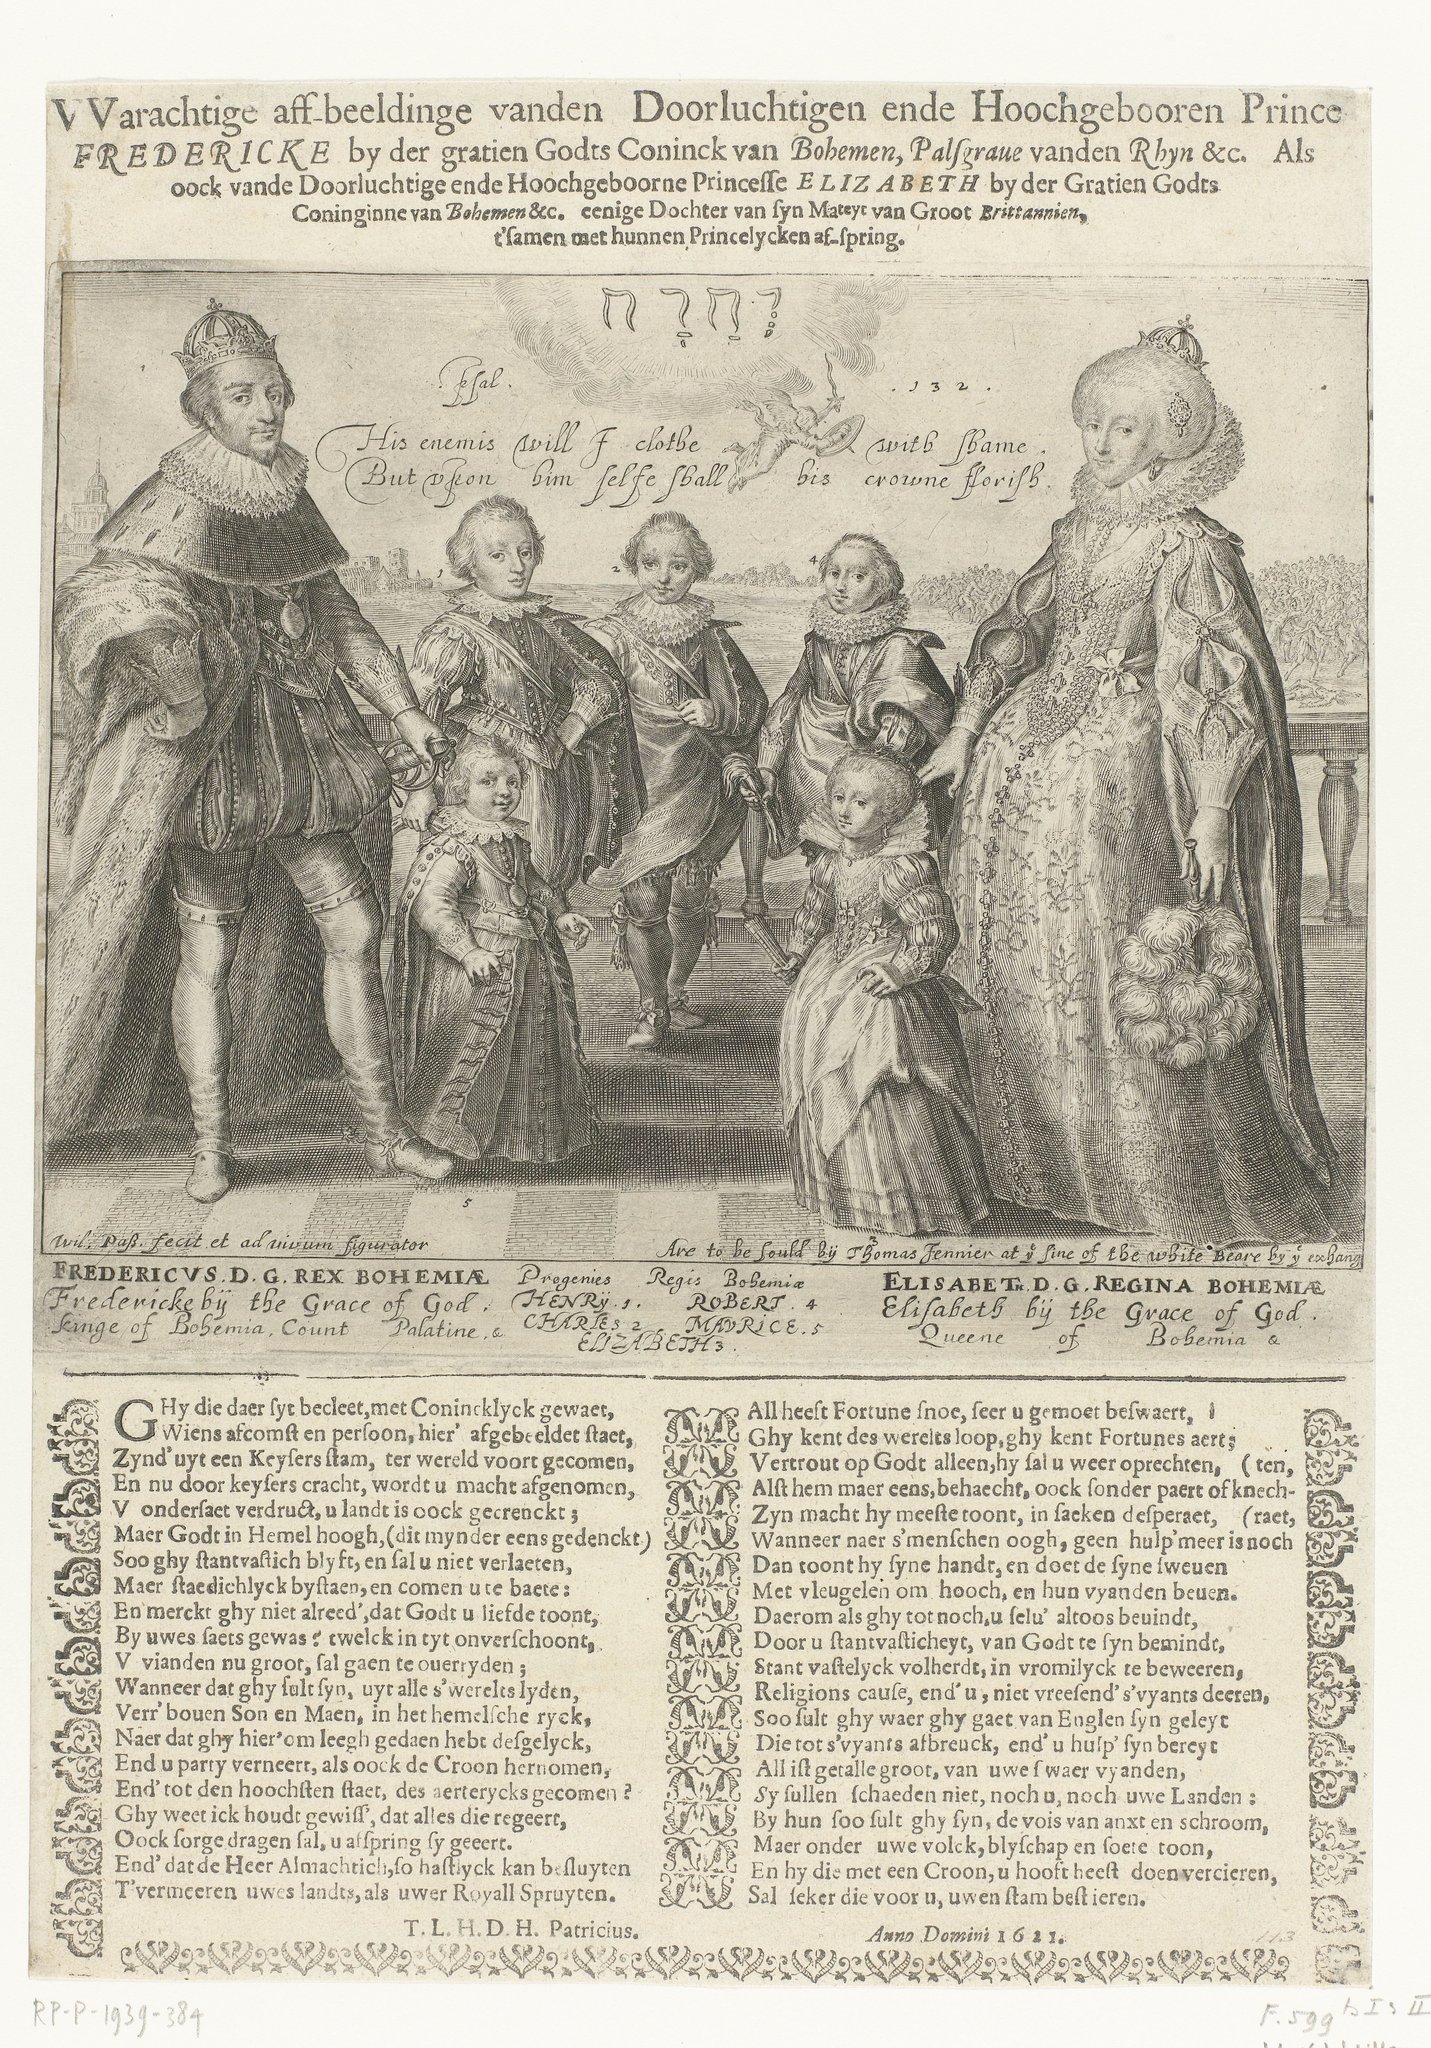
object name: print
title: Portret van Frederik V van Bohemen, zijn echtgenote Elisabeth Stuart en hun vijf kinderen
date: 1621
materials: paper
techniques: engraving, letterpress printing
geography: london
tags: prague, london, painter, draughtsman, prinz ruprecht, amberg, frederik v (keurvorst van de palts, koning van bohemen), tetragram (in hebrew script) ~ jewish religion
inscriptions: collector's mark: Lugt 2760, collector's mark: Lugt 2166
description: Portret van Frederik V, zijn echtgenote Elisabeth Stuart, koning en koningin van Bohemen, en hun vijf kinderen: Hendrik Frederik, Karel I Lodewijk, Elisabeth, Ruprecht en Maurits van de Palts. In de hemel het tetragram met de naam van God en een tweeregelig Bijbelcitaat uit Ps. 132 in het Engels. In de marge de namen en functie van de geportretteerden in het Engels. Onder de prent een veertigregelig gedicht, in twee kolommen, in het Nederlands.